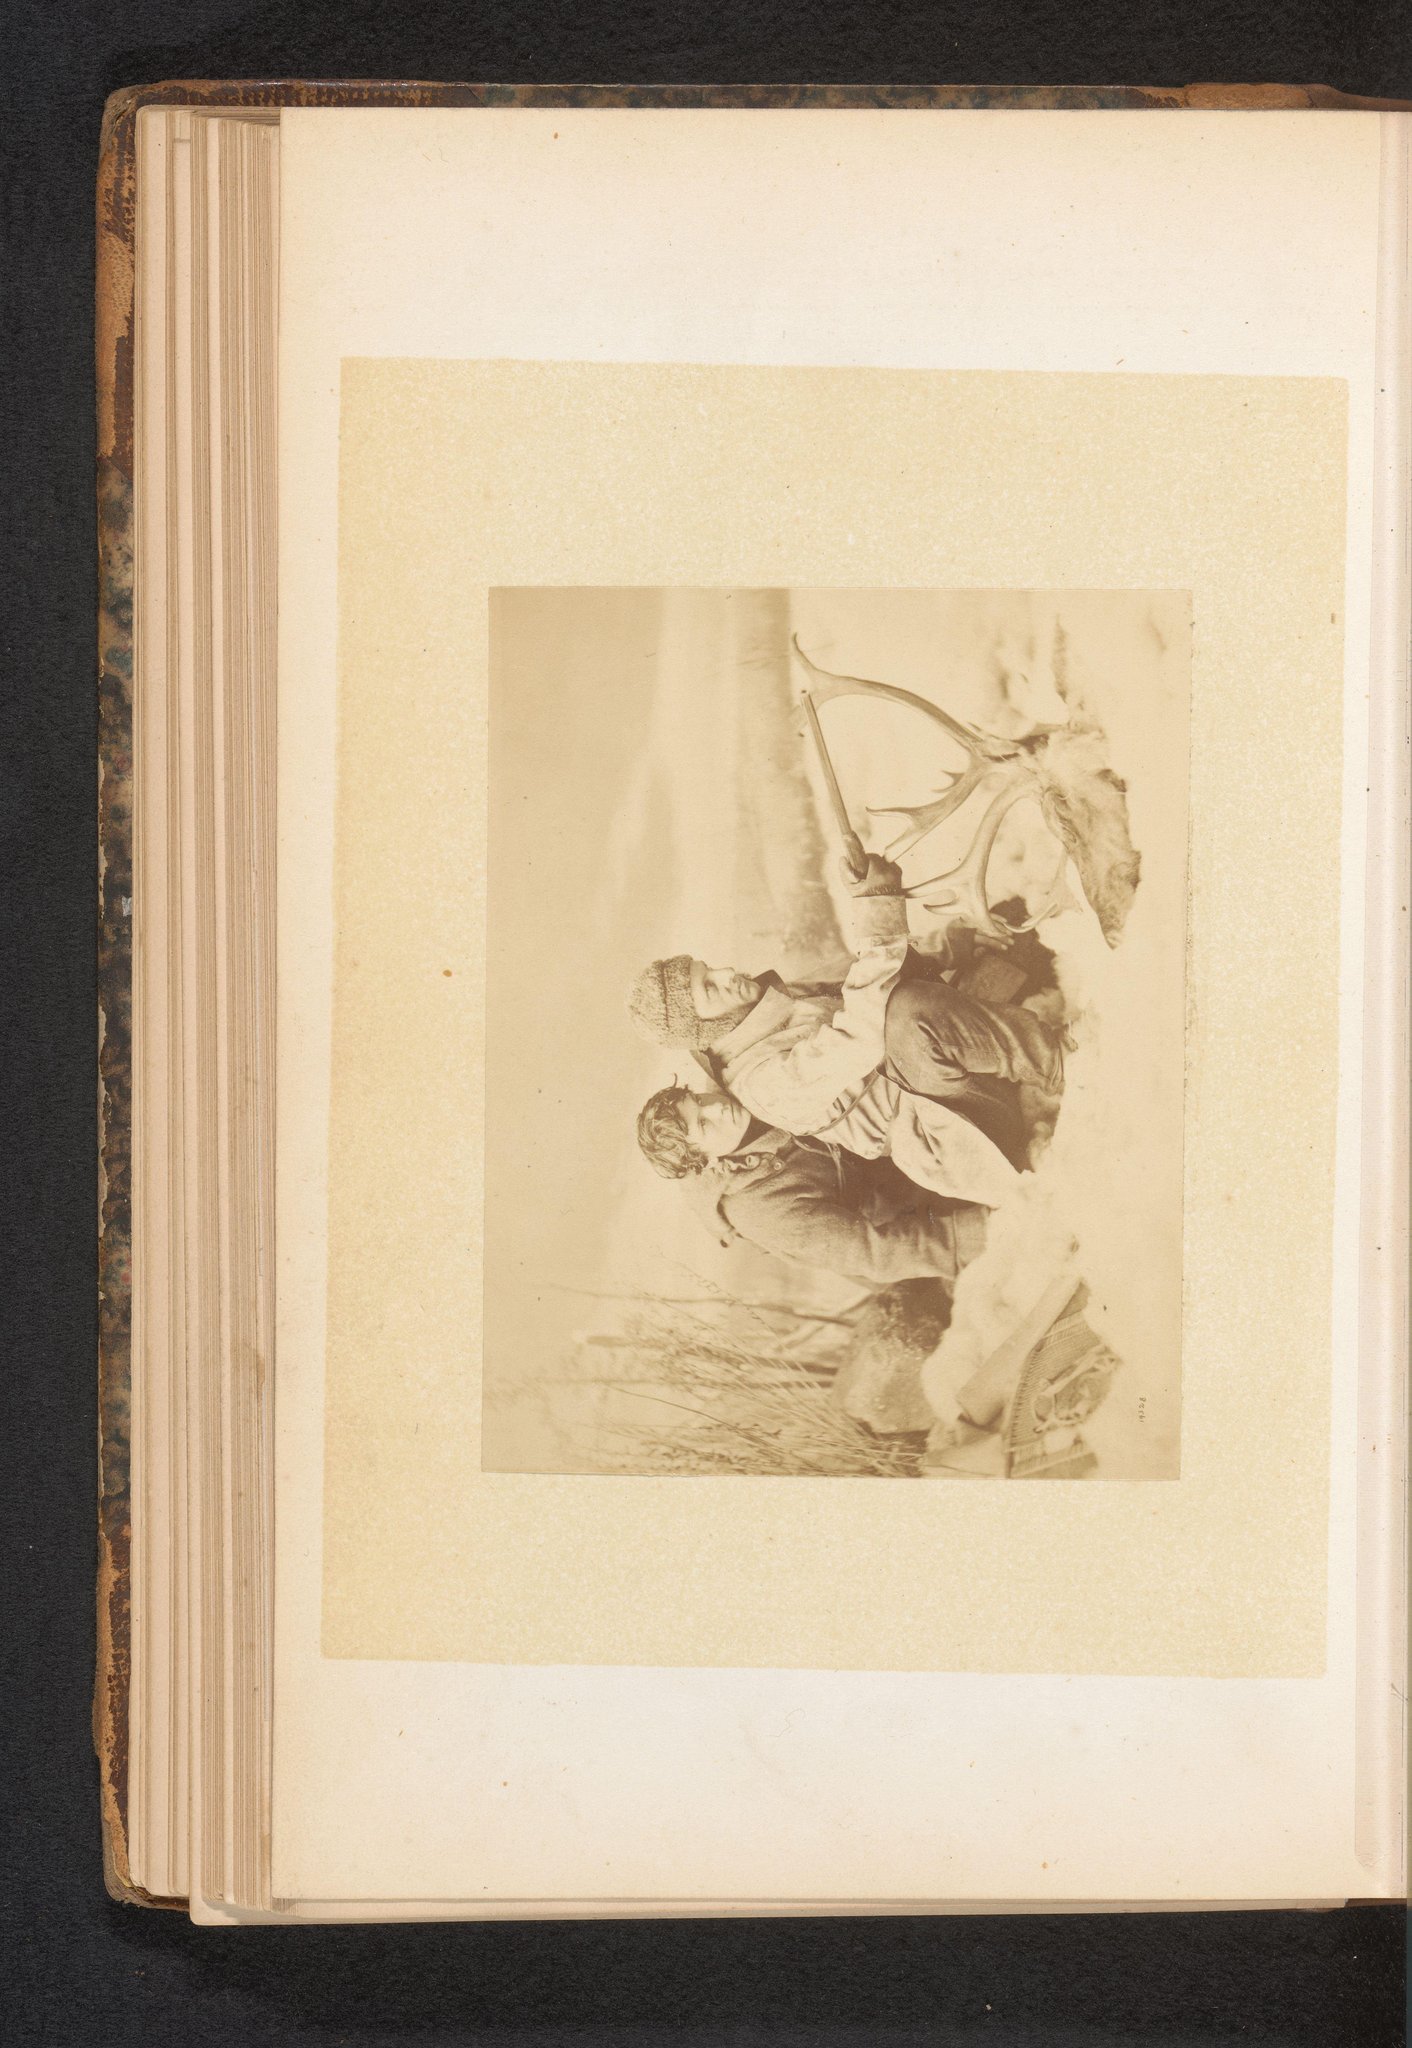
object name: page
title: Twee mannen met een pistool en een gewei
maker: william notman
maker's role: fotograaf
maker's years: 1826-1891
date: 1861-1866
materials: photographic support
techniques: albumen print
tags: adult man, firearms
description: Foto tegenover pagina 129, achter semi-transparante omslag.